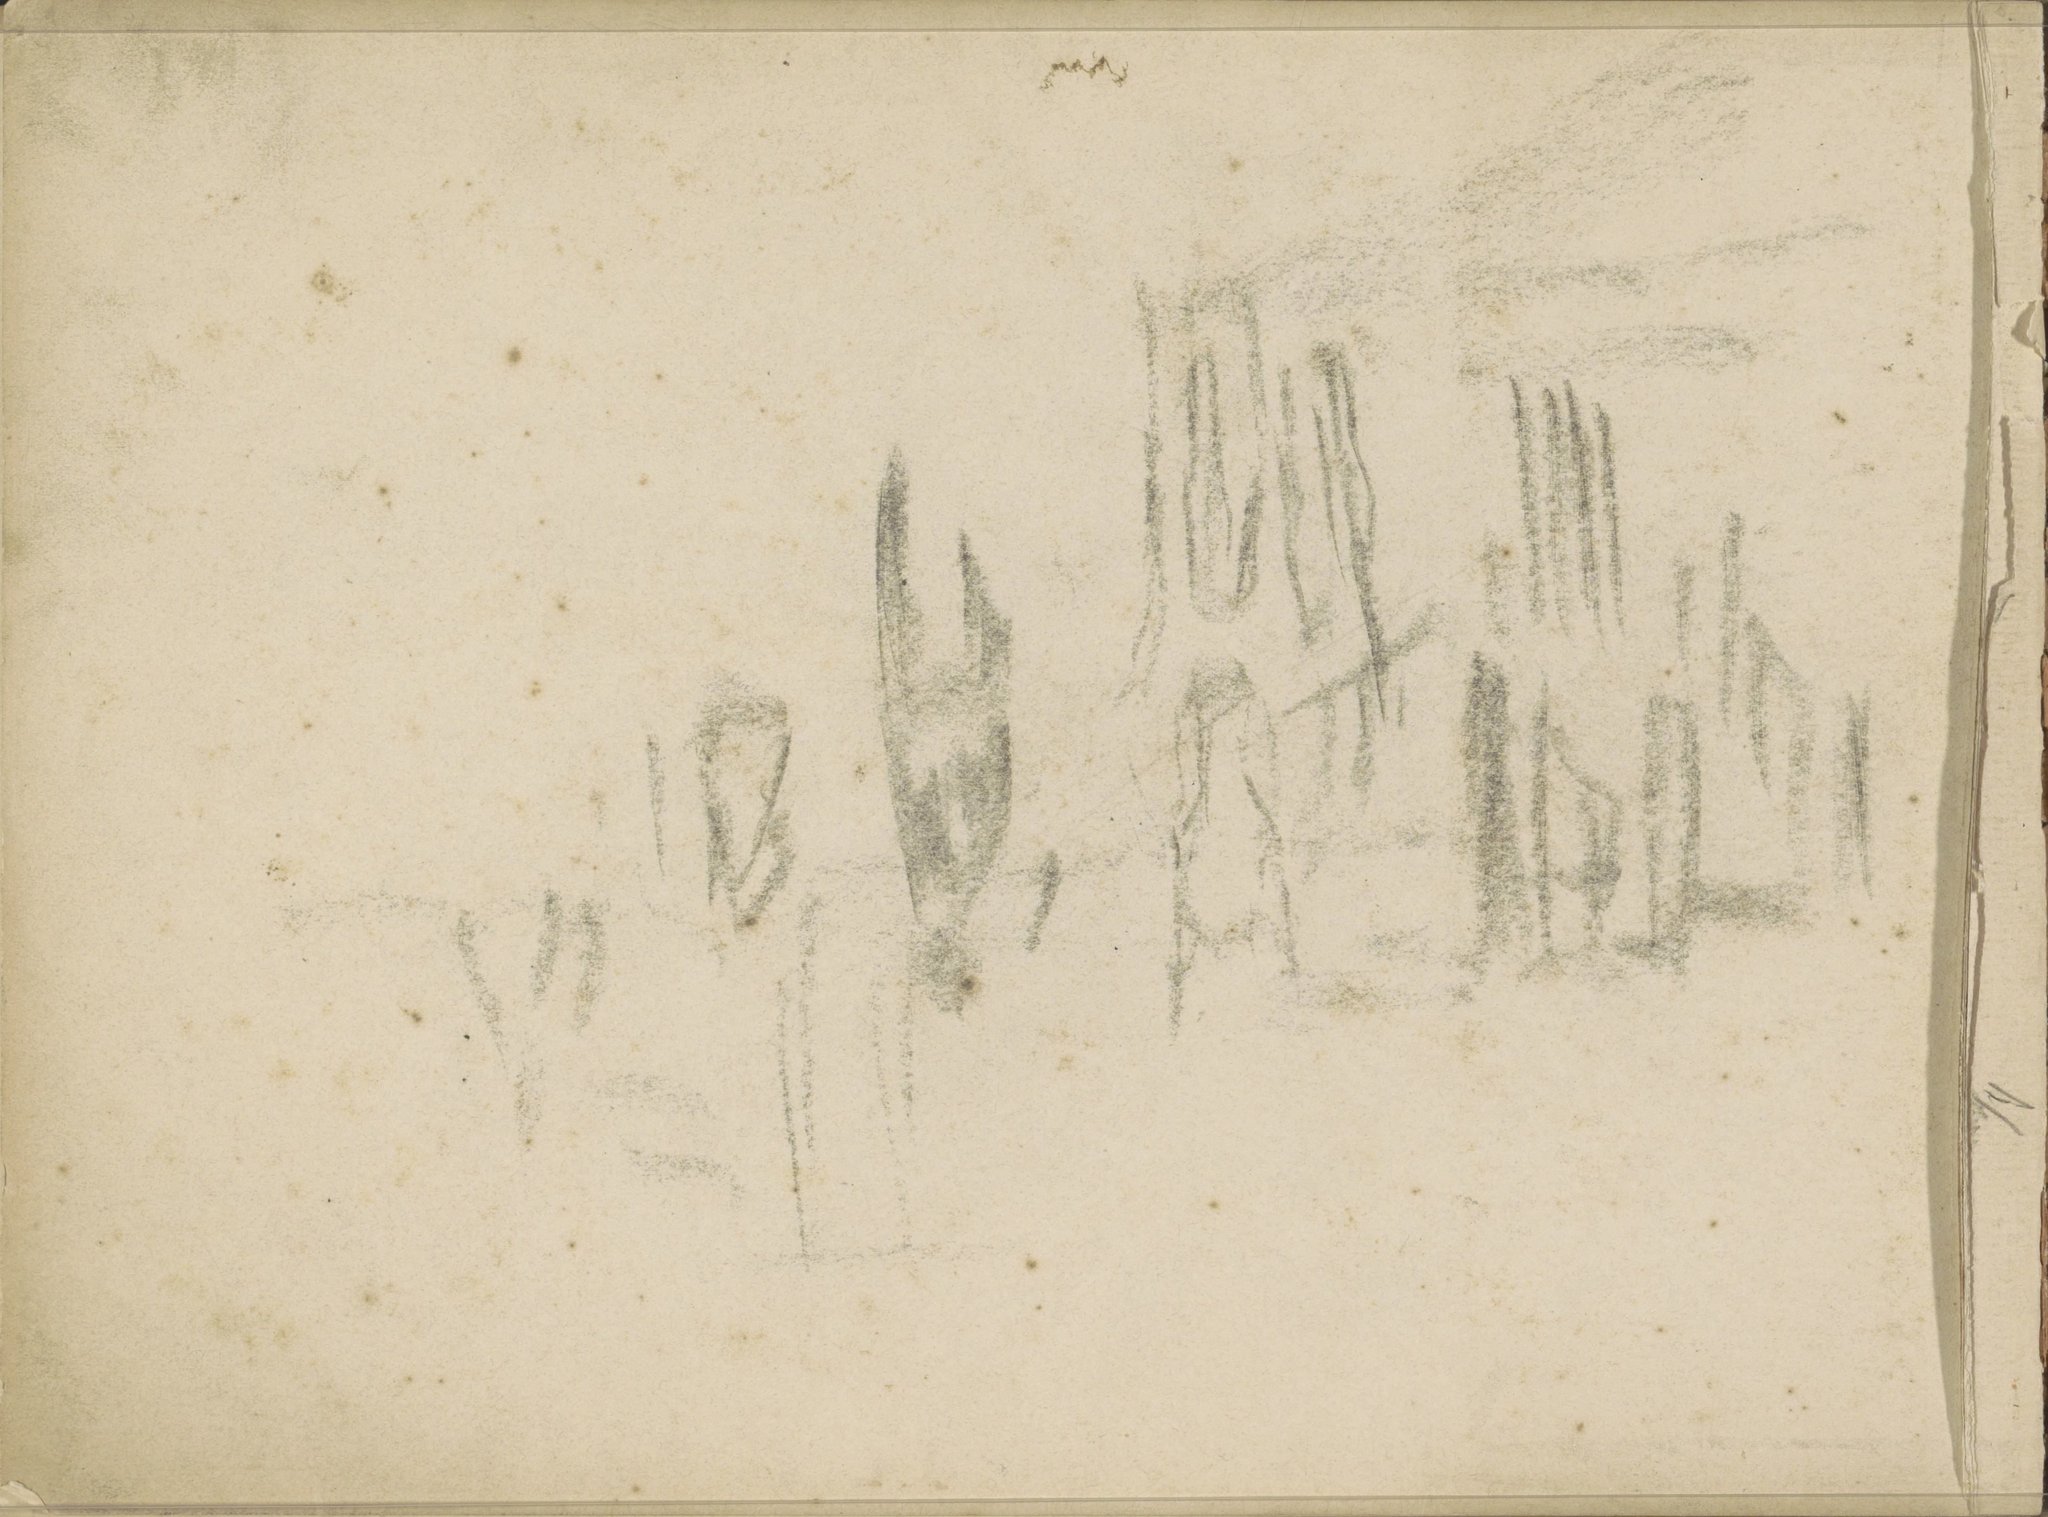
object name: sketchbook leaf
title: Figuren en een aangespannen paard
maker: george hendrik breitner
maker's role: draughtsman, painter, print maker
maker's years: 1857-1923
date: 1886-1923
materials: chalk, paper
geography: amsterdam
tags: adult man, horse, city-view, and landscape with man-made constructions (+ city(-scape) with figures, staffage)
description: Pagina 18 uit een schetsboek met 9 bladen.